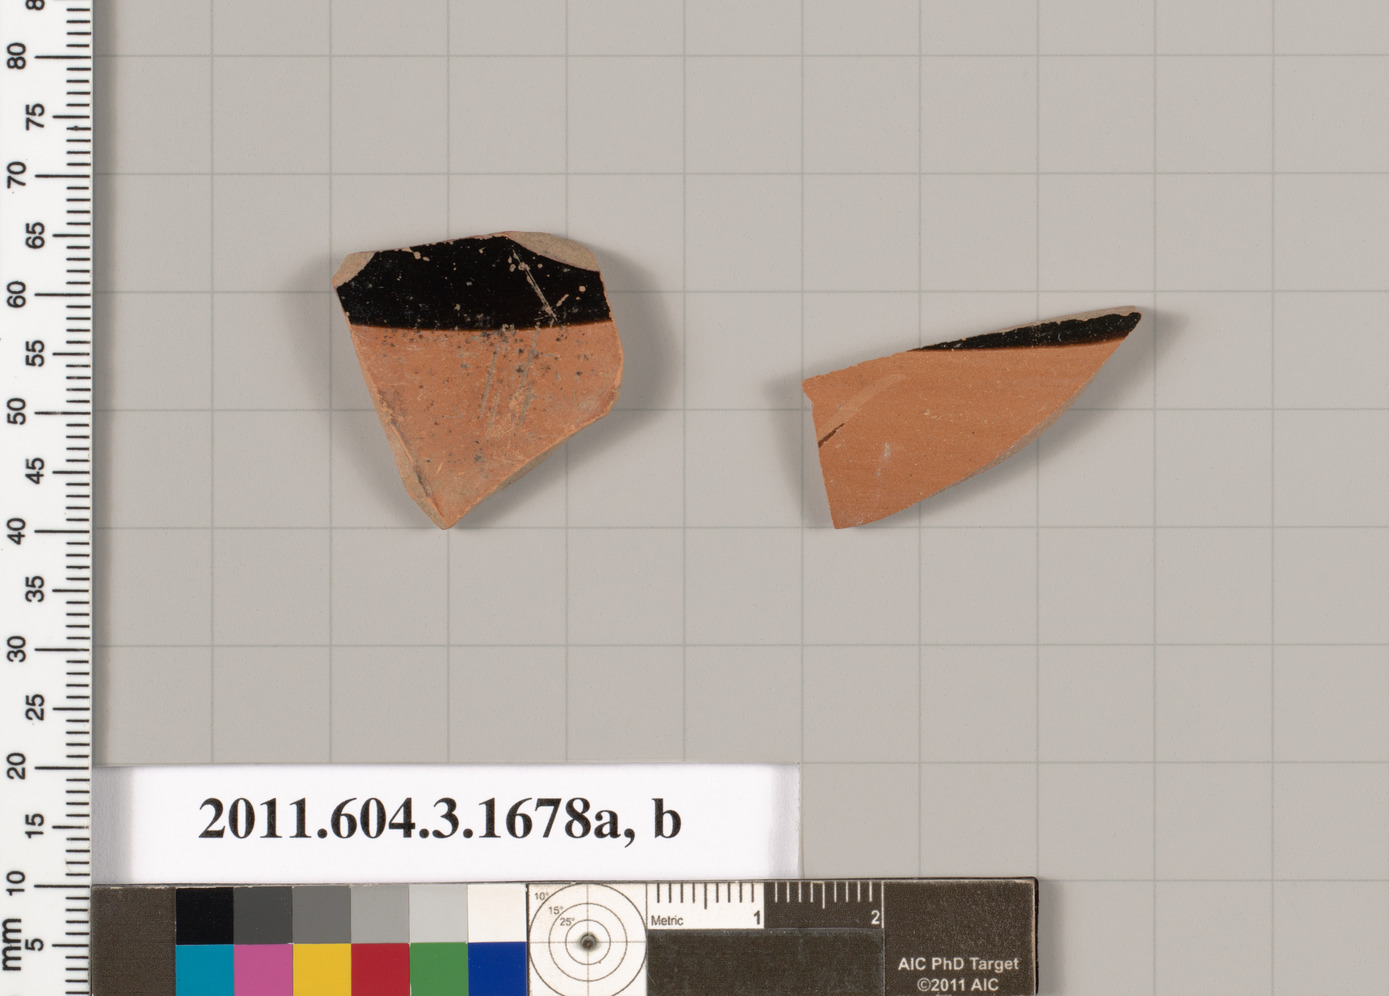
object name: kylix fragment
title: Terracotta fragments of kylikes: Band or lip cups (drinking cups)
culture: greek, attic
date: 550-526 BCE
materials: terracotta